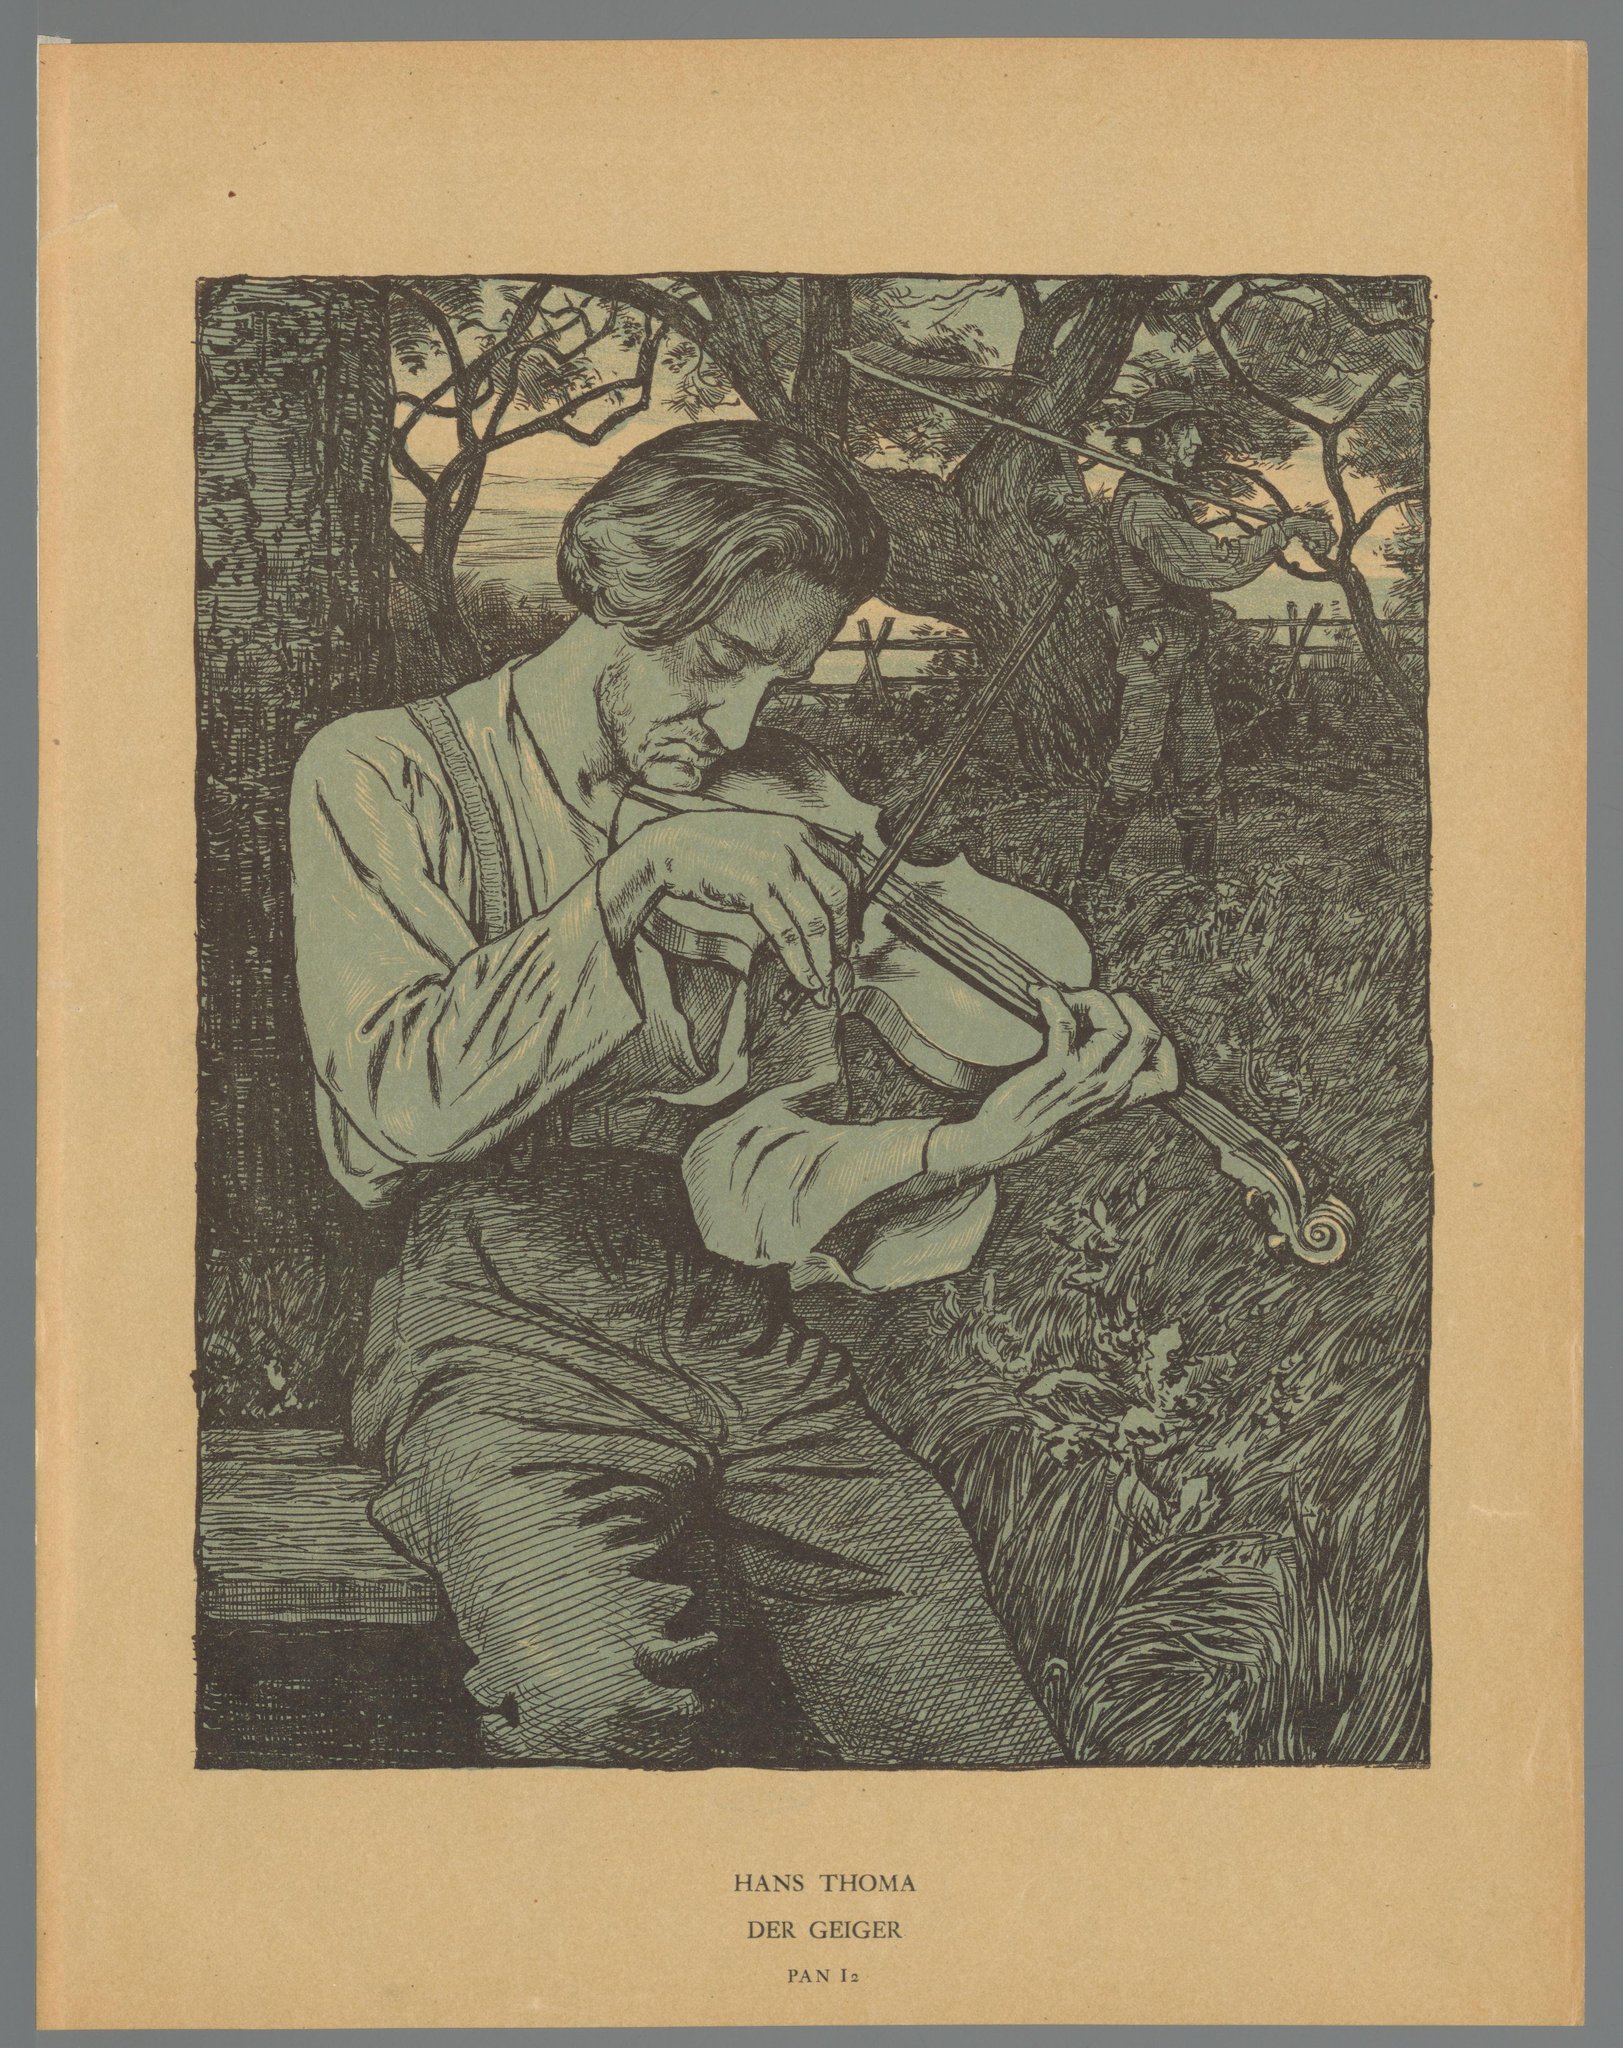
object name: print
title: Man met viool bij een boom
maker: hans thoma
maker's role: painter, print maker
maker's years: 1839-1924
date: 1895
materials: paper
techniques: tone lithography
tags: one person playing string instrument (bowed), adult man, violin, fiddle - cc - out of doors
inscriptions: collector's mark: Lugt 2228